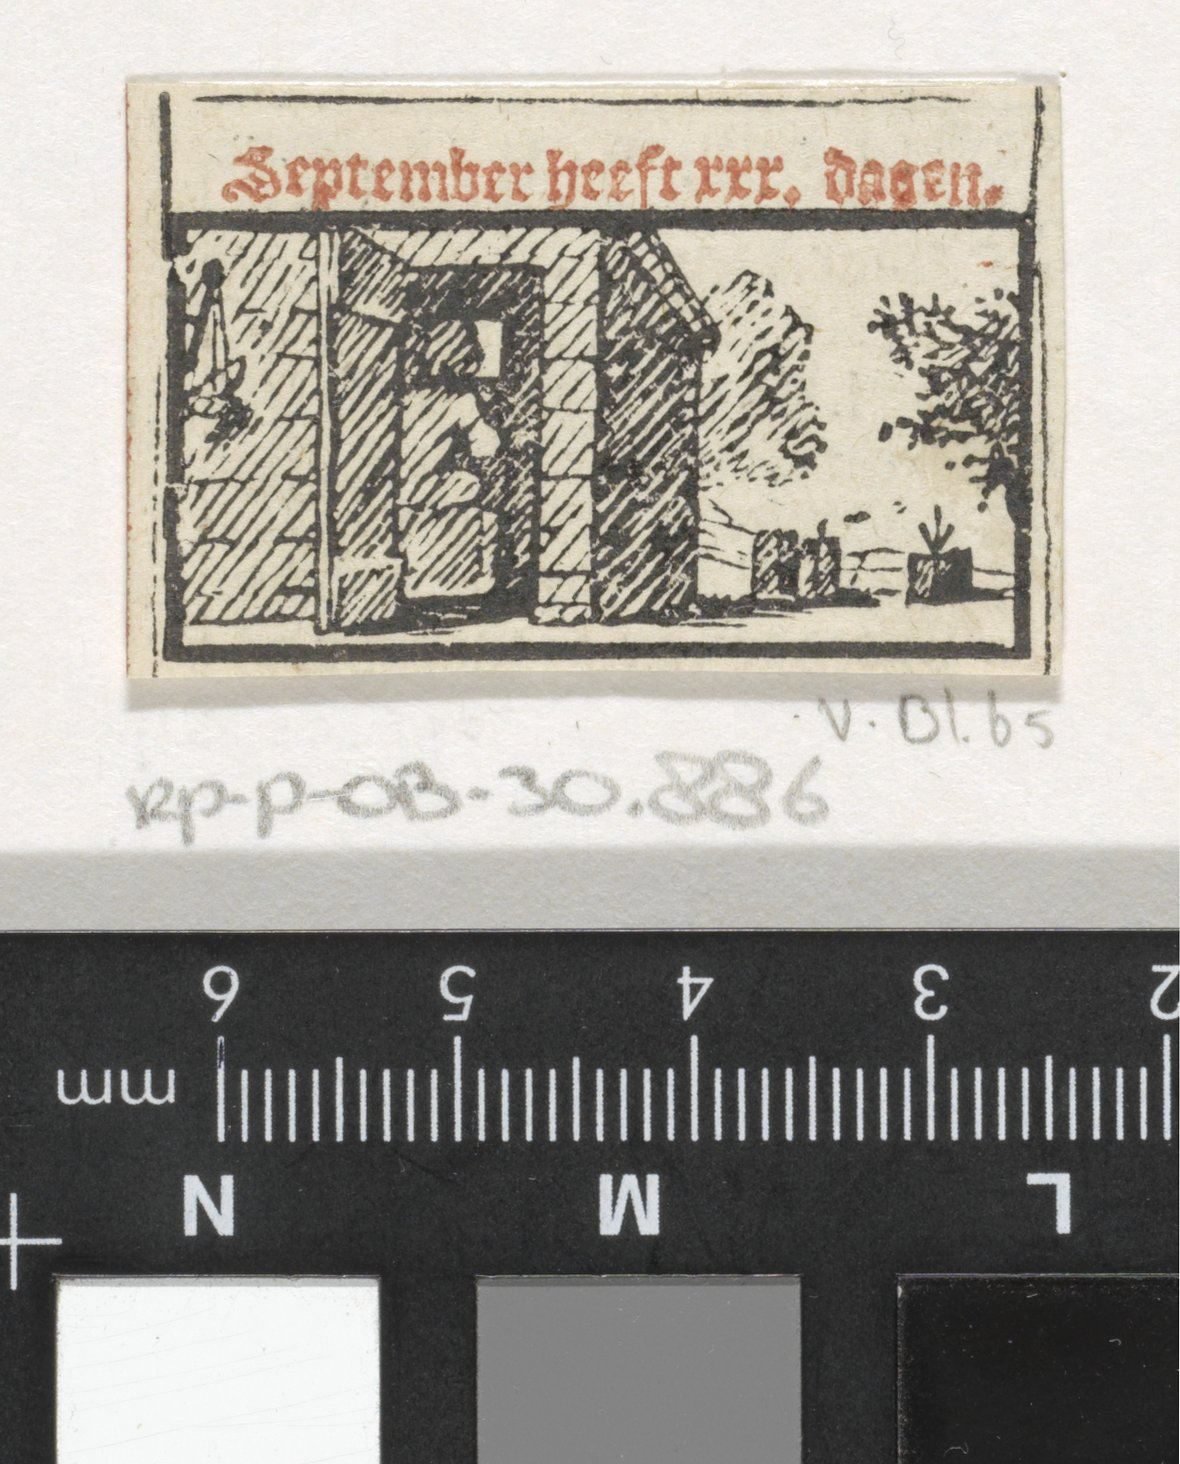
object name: print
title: Maanden van het jaar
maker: dirck de bray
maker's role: draughtsman, painter, print maker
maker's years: 1625-1694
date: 1635-1694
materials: paper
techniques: letterpress printing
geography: netherlands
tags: september and its 'labours' (+ with libra (september))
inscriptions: collector's mark: Lugt 2228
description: Een putto kijkt vanuit een hut door een klein venster naar buiten. Aan de hut hangt een weegschaal. In de bovenmarge een regel Nederlandse tekst.